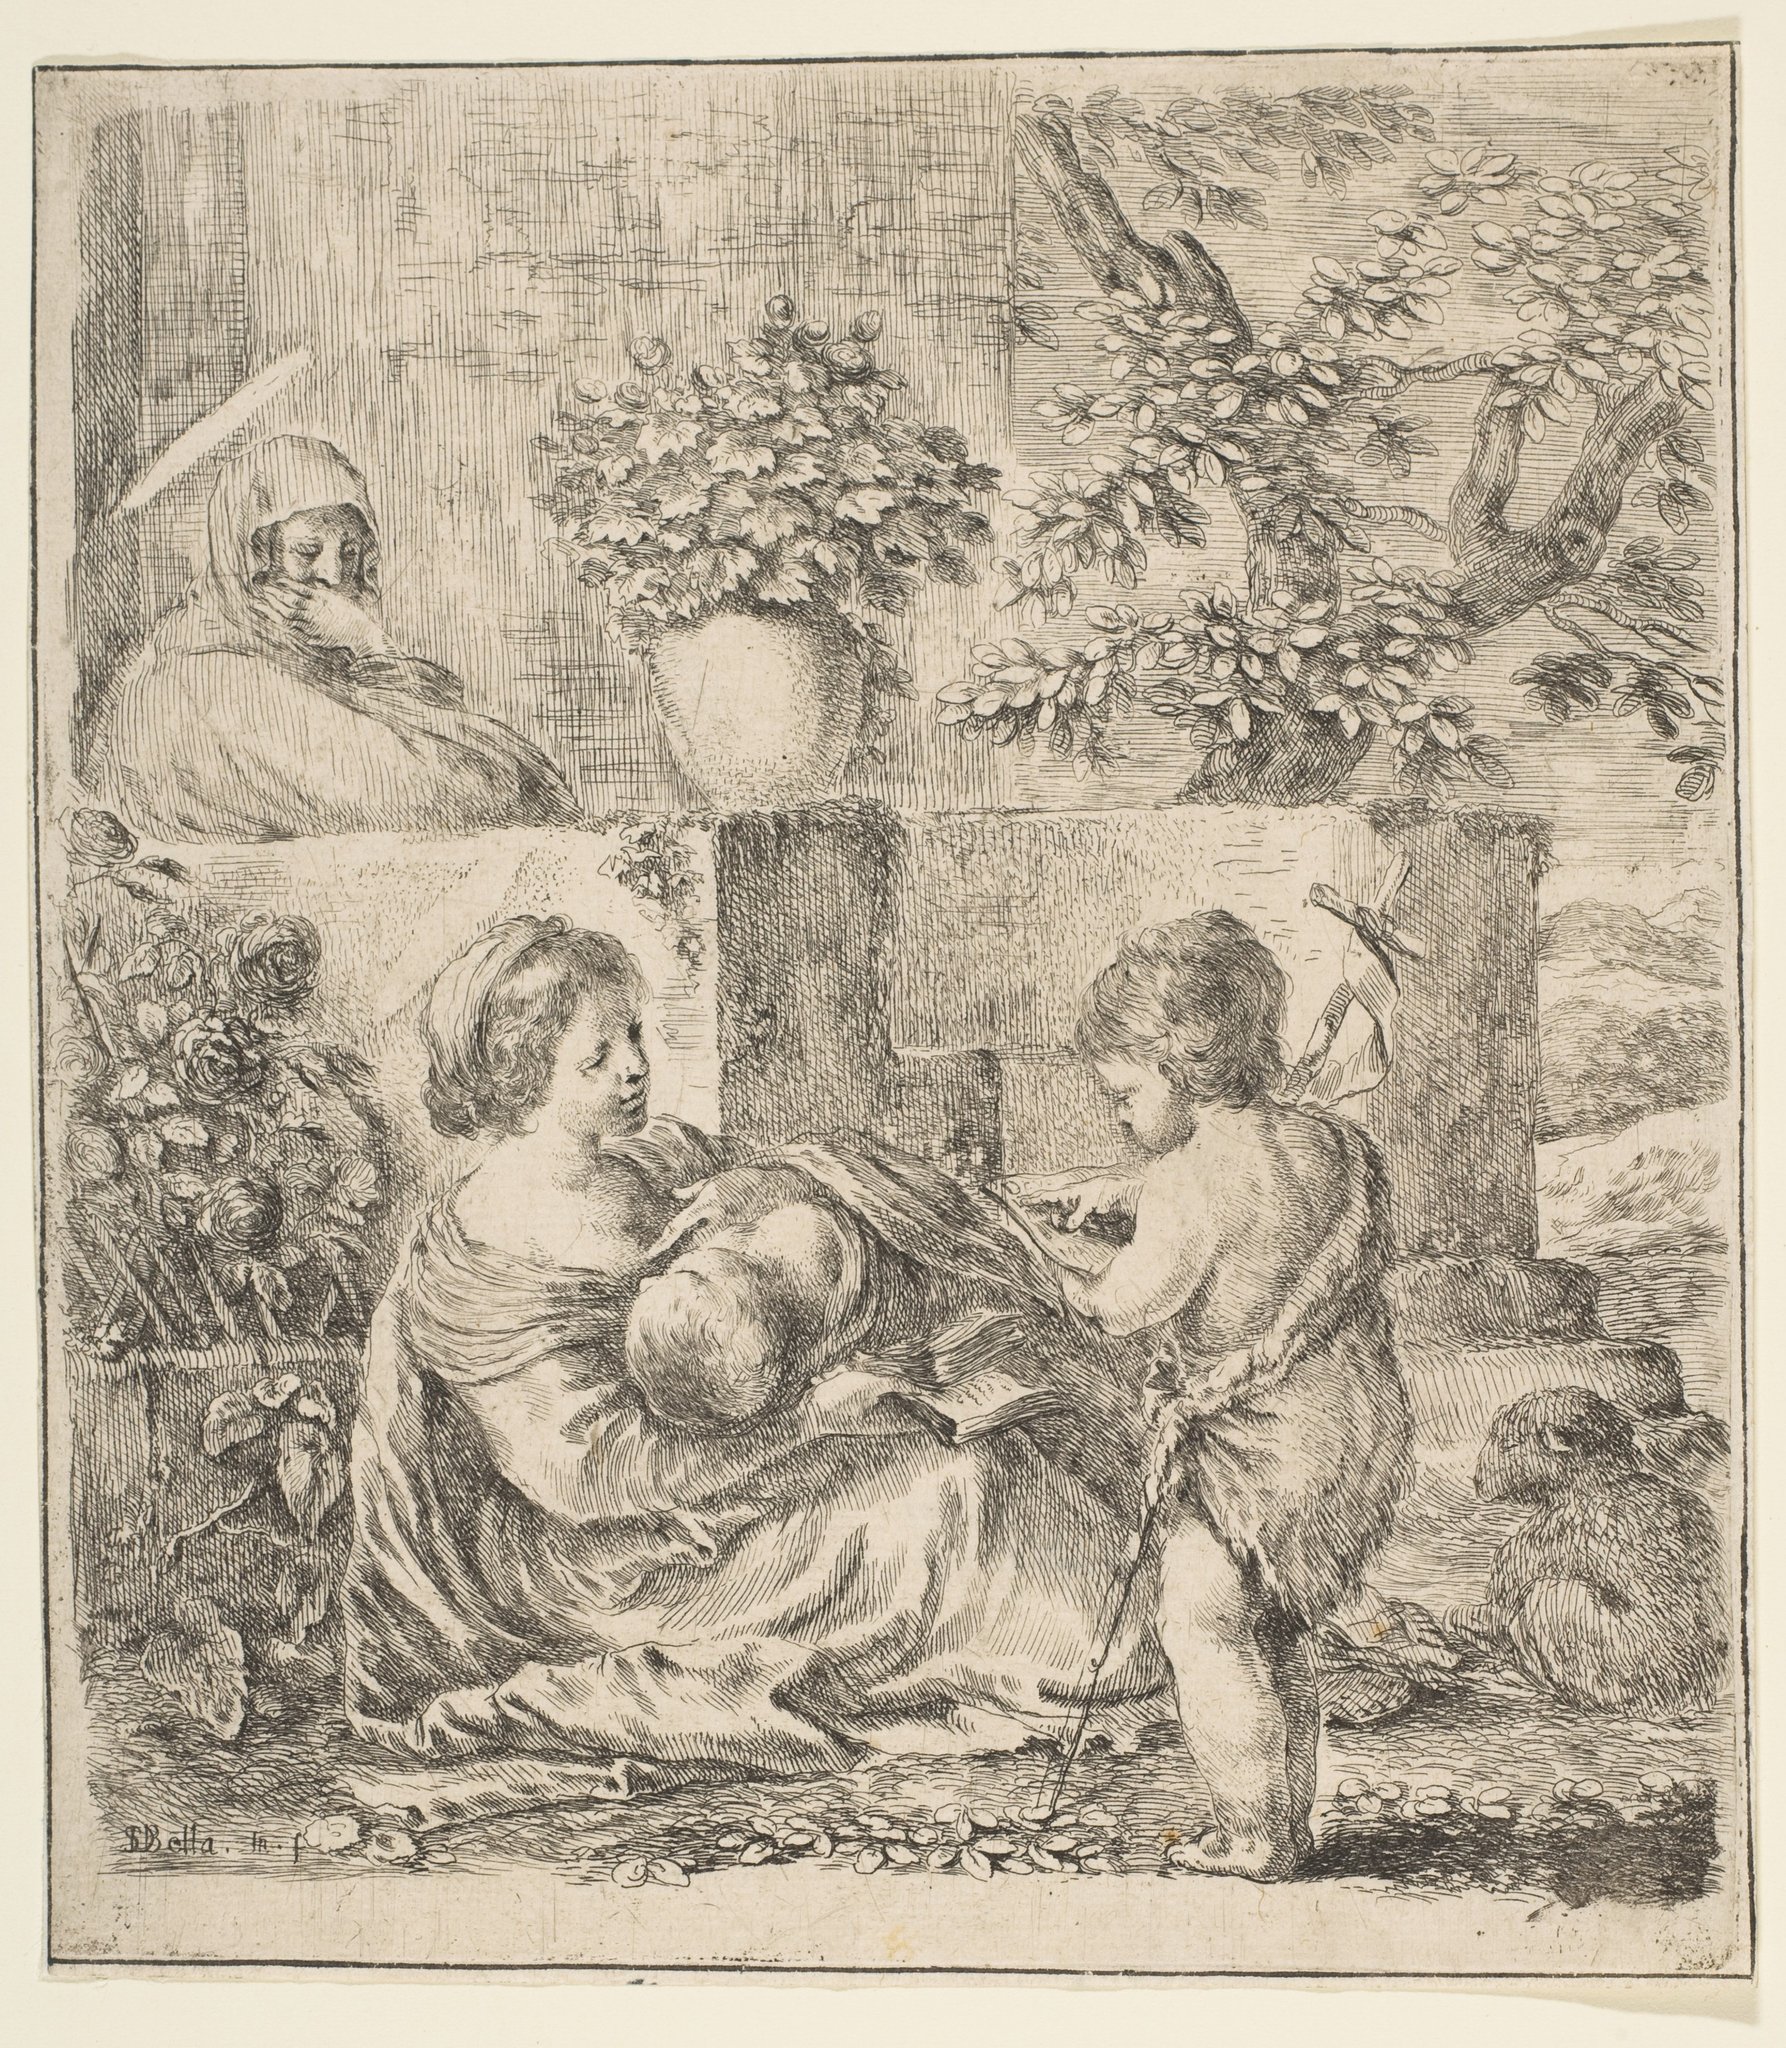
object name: print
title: Virgin and Child with St. John the Baptist and St. Elizabeth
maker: stefano della bella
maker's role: artist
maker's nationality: italian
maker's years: 1610-1664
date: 1641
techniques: etching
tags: madonna and child,saint john the baptist